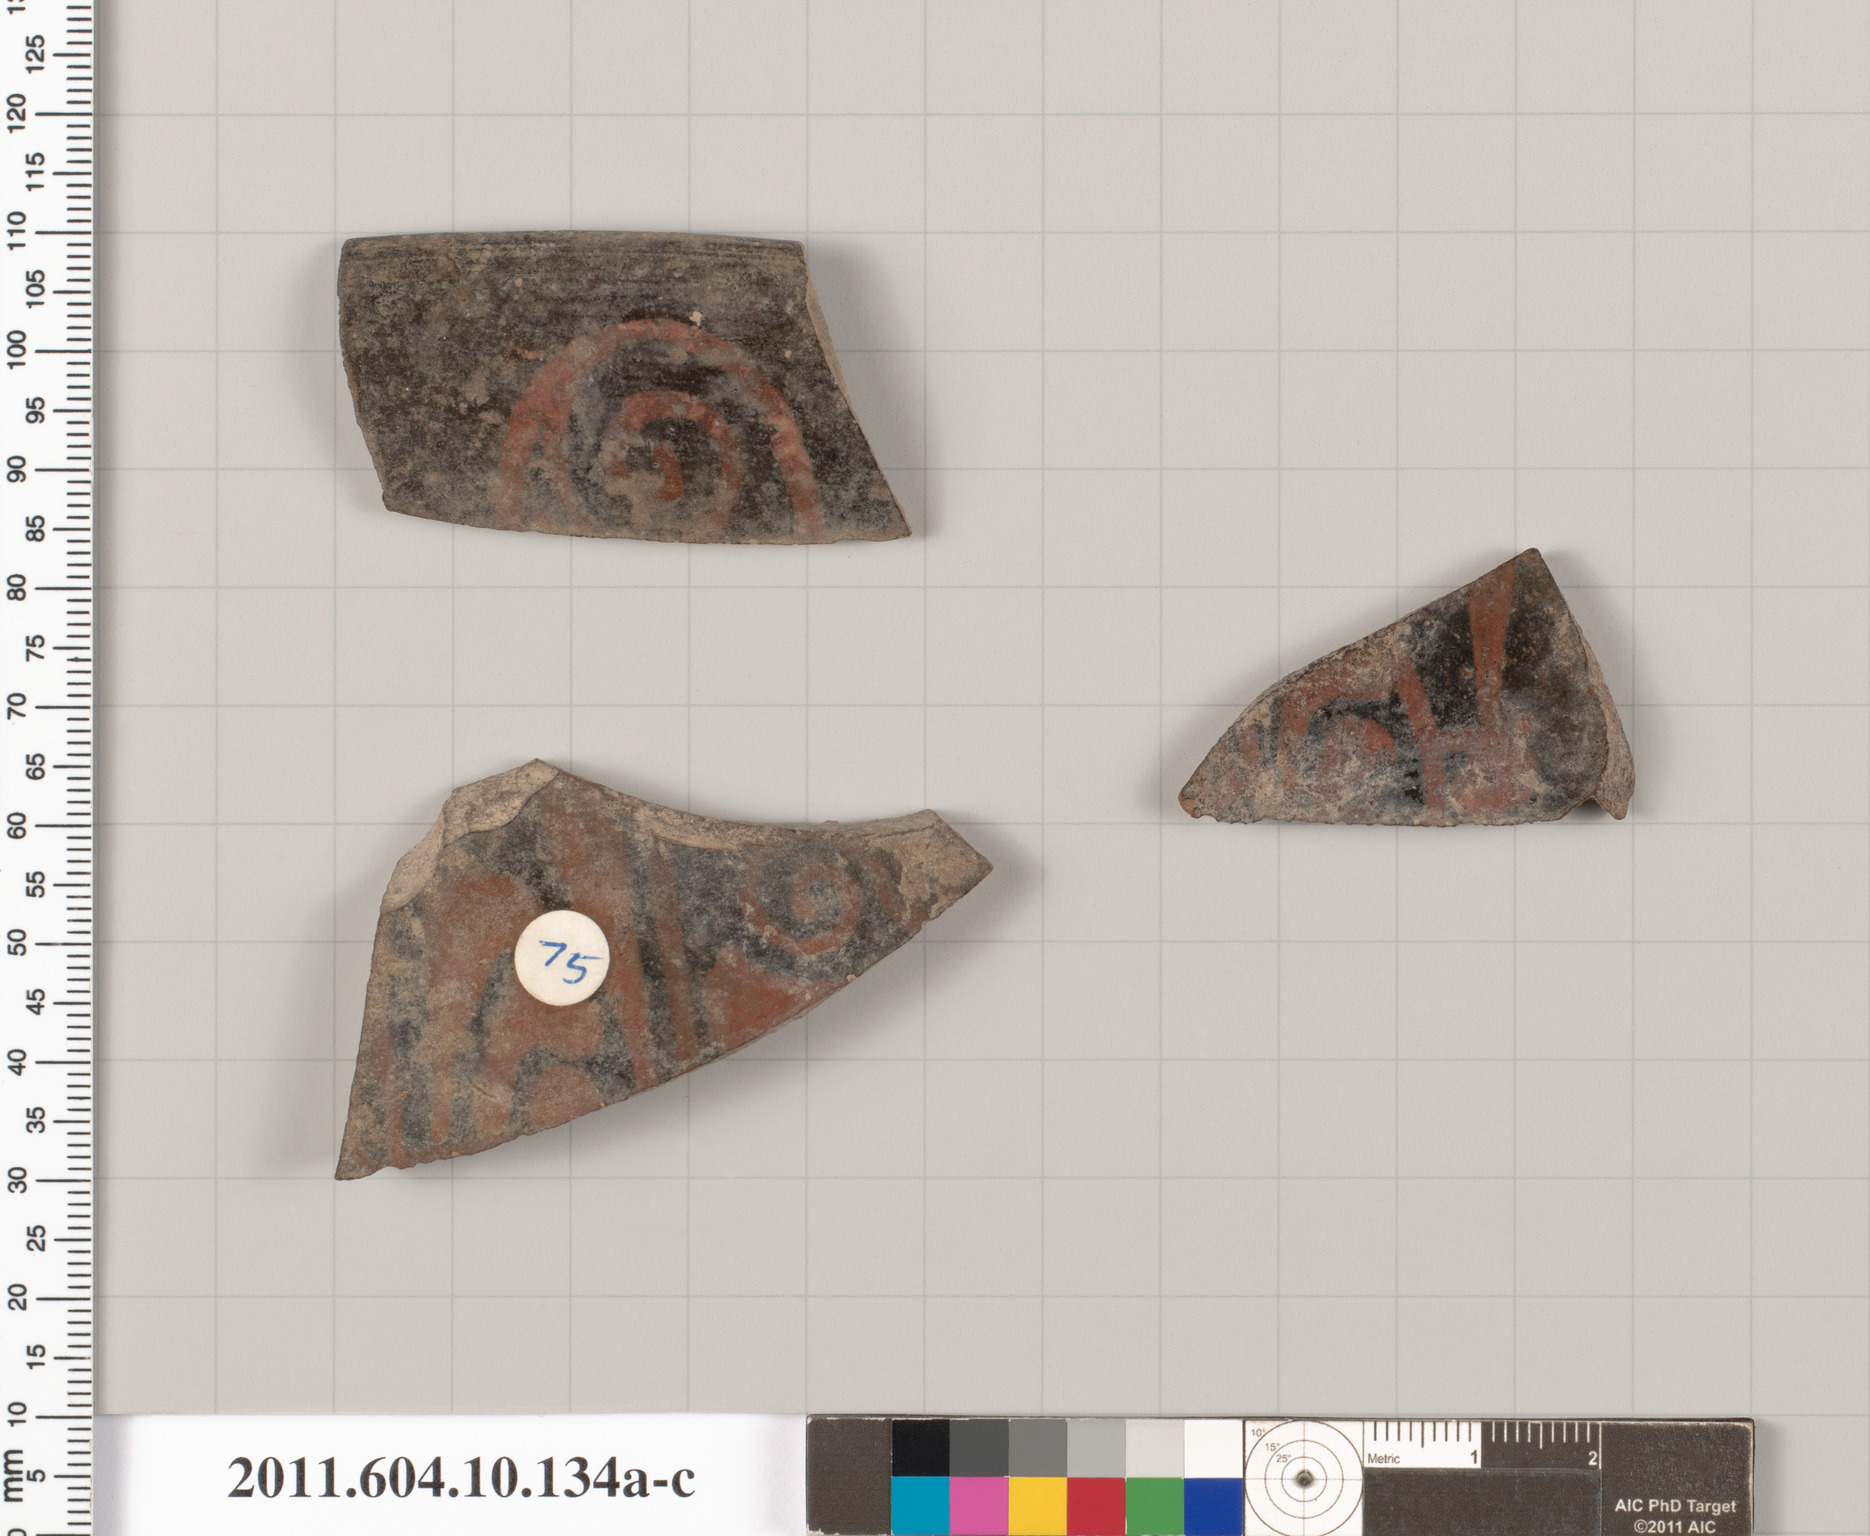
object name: kylix fragment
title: Terracotta fragments of a kylix (drinking cup)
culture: etruscan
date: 434-401 BCE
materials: terracotta